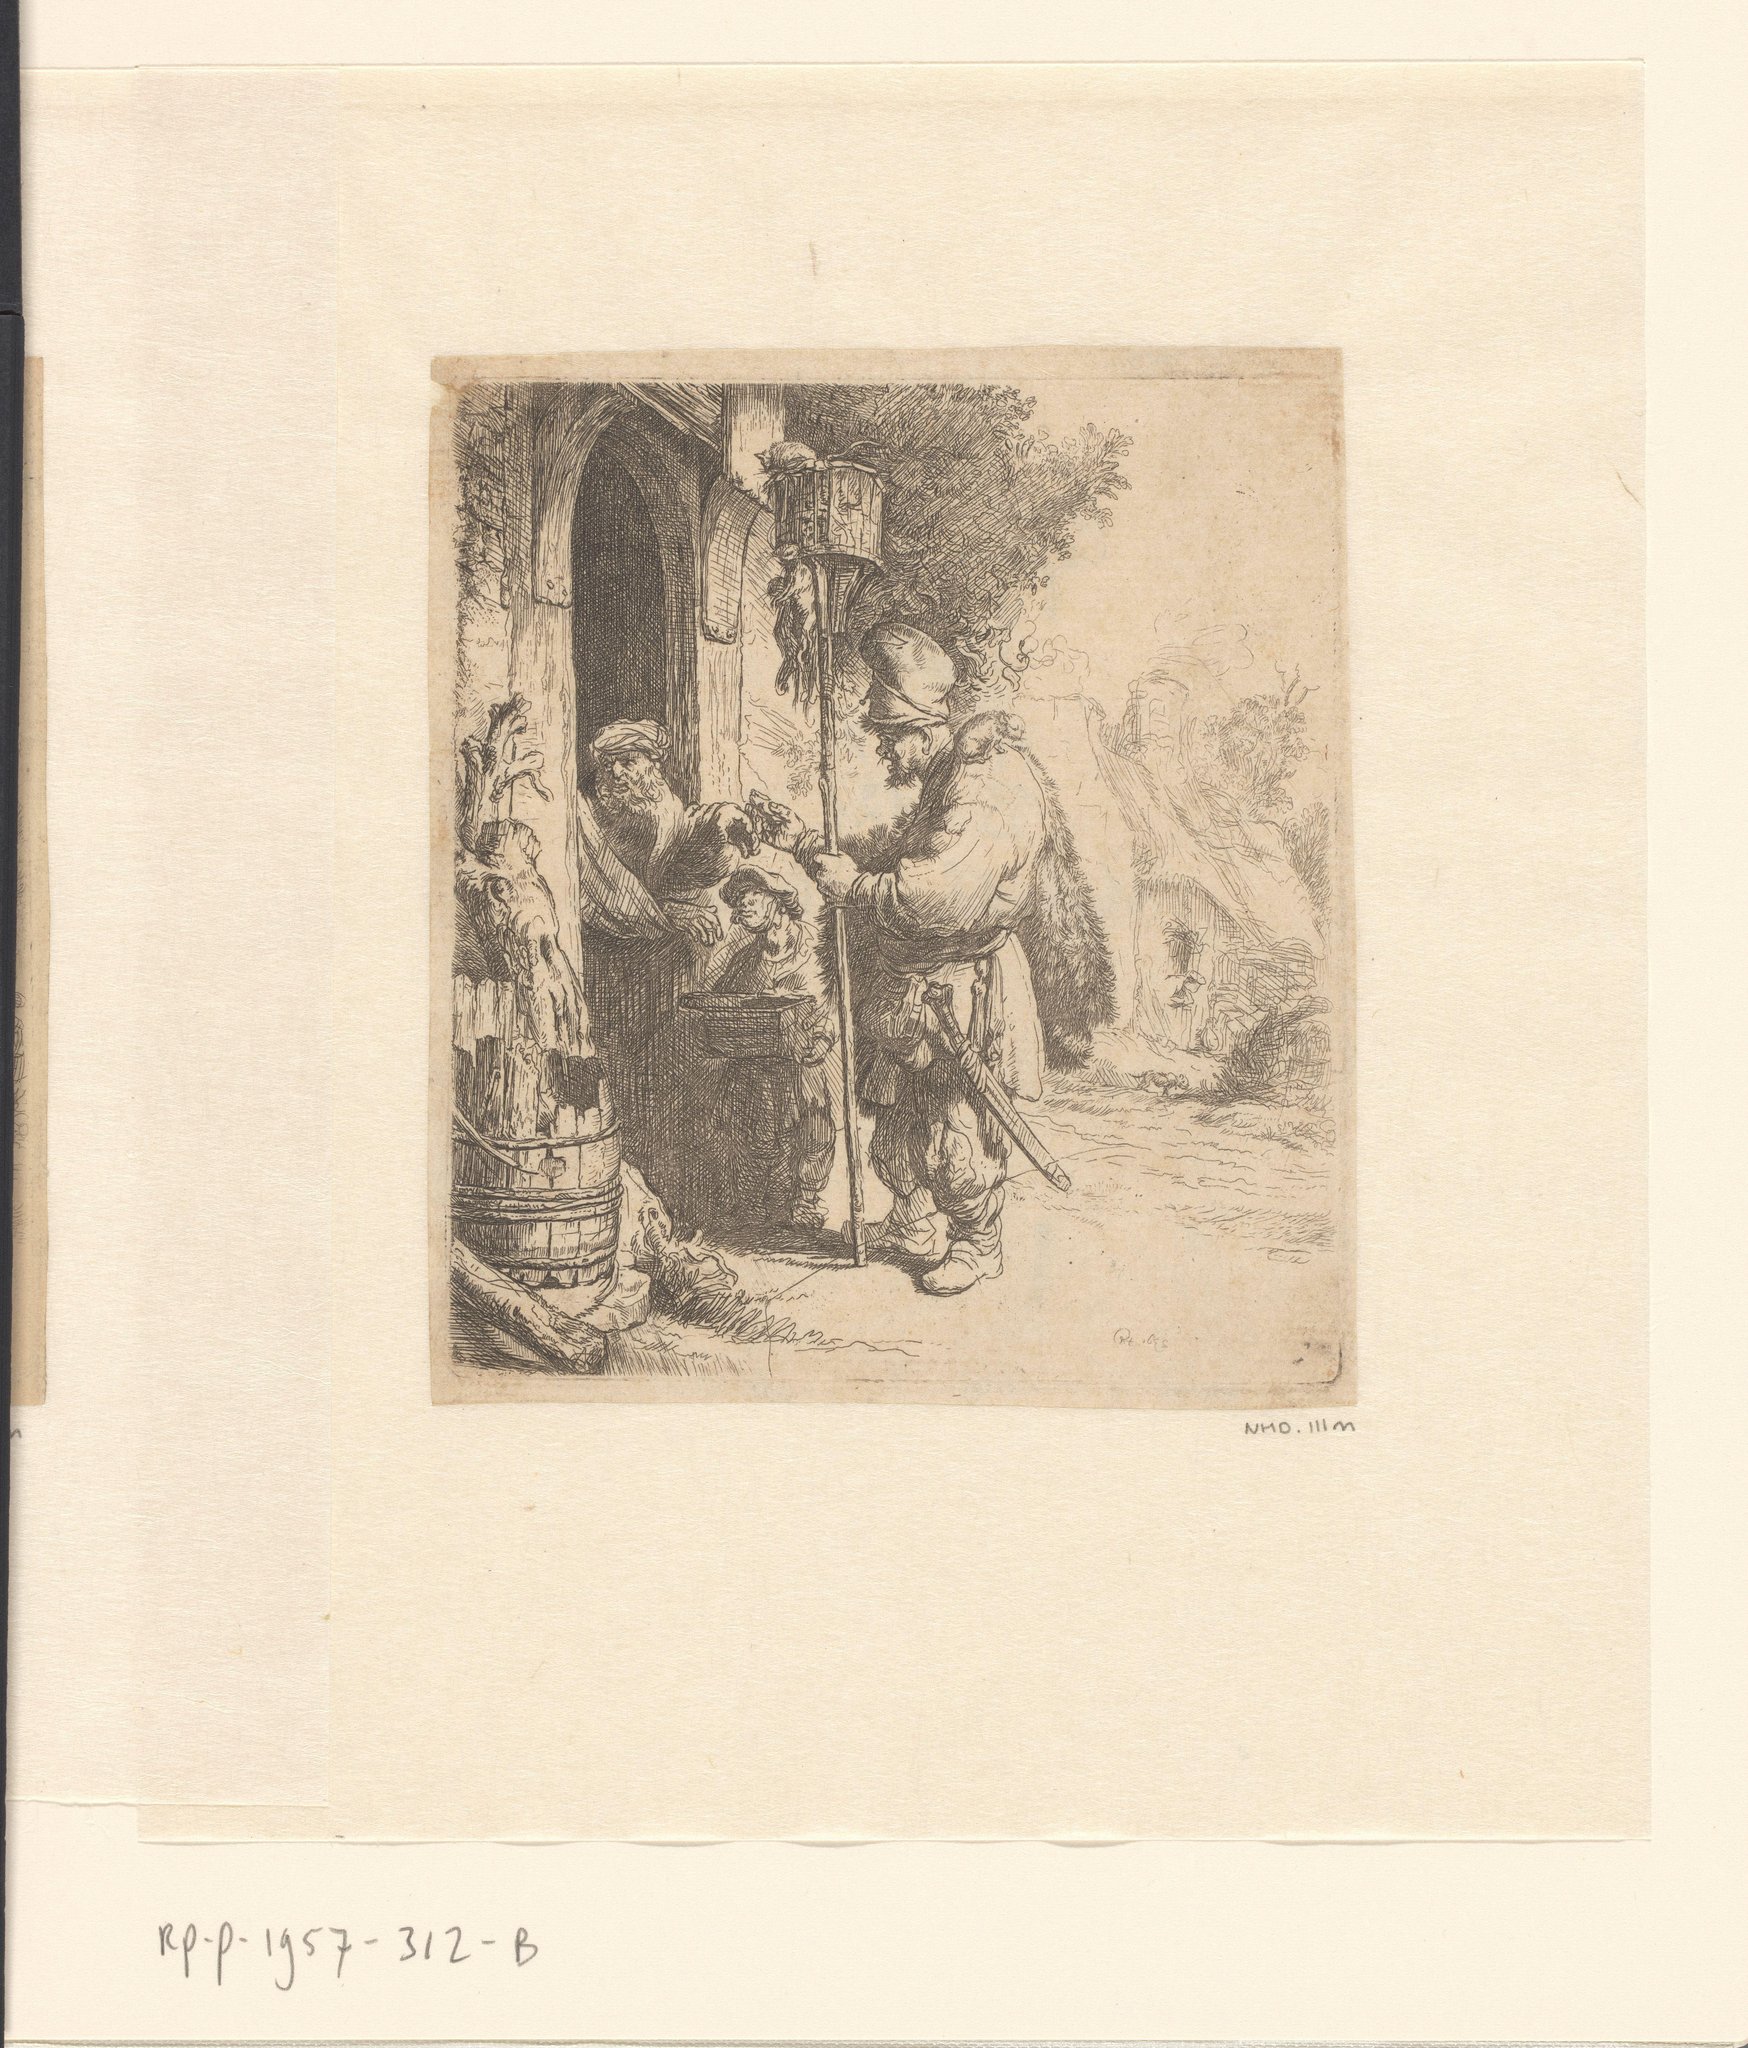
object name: print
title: The rat catcher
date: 1760-1781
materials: paper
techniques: engraving, etching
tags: rat exterminator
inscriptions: collector's mark: Lugt 2228, collector's mark: Lugt 2760